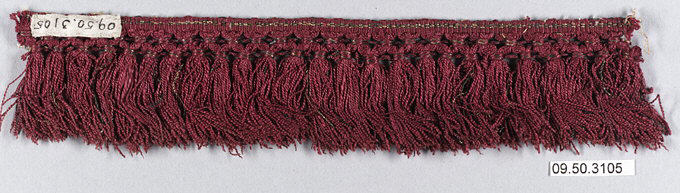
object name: fringe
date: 1701-1900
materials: metal thread, silk